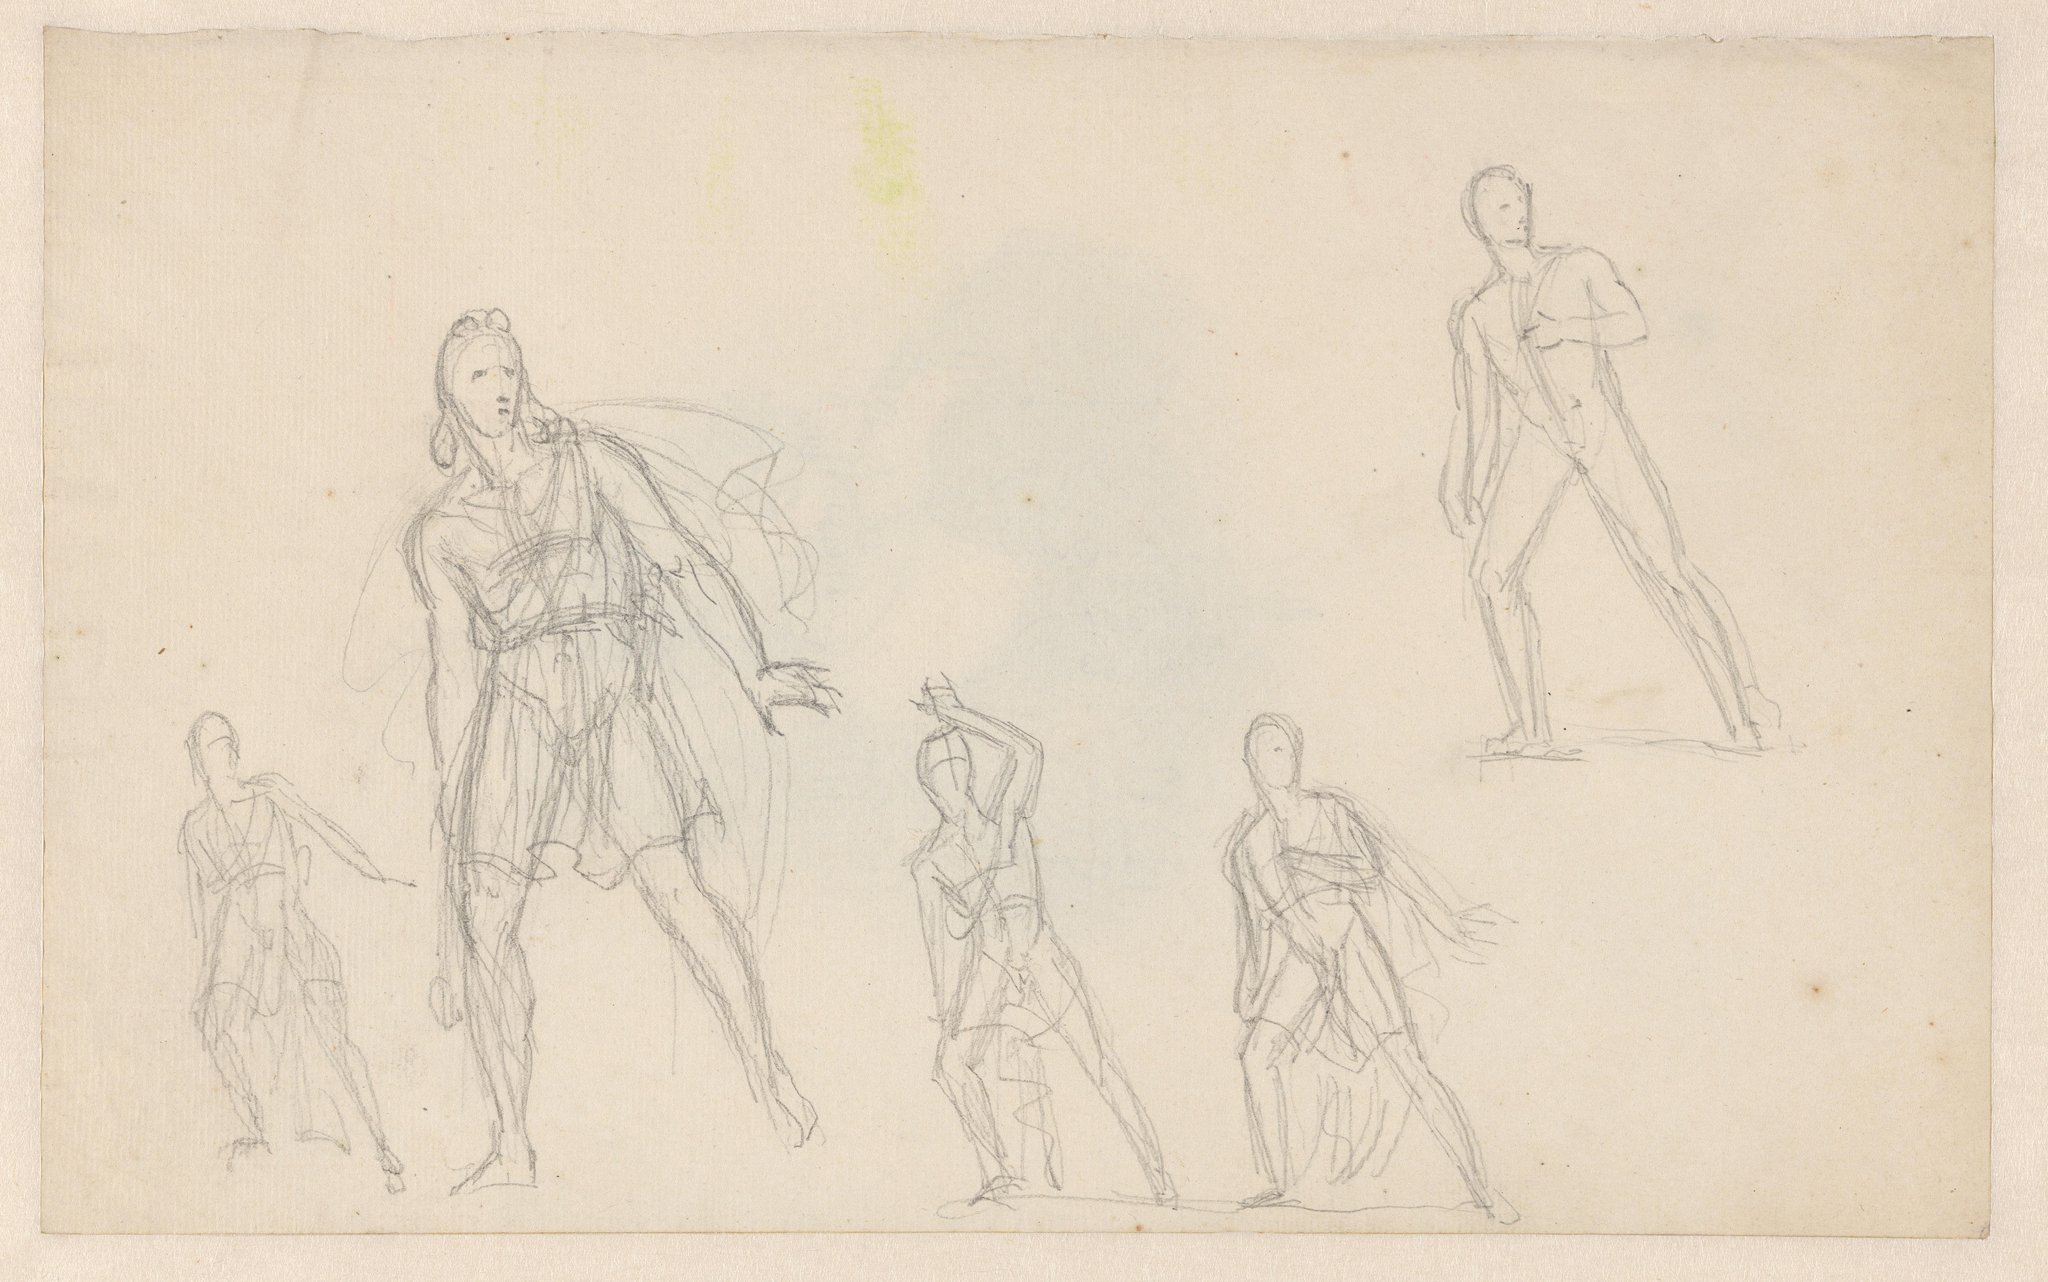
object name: drawing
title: Figuurstudies van een man leunend op zijn rechter been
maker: louis royer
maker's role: draughtsman, sculptor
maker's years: 1793-1868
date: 1808-1868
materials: paper, pencil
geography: netherlands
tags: making music; musician with instrument, youth, adolescent